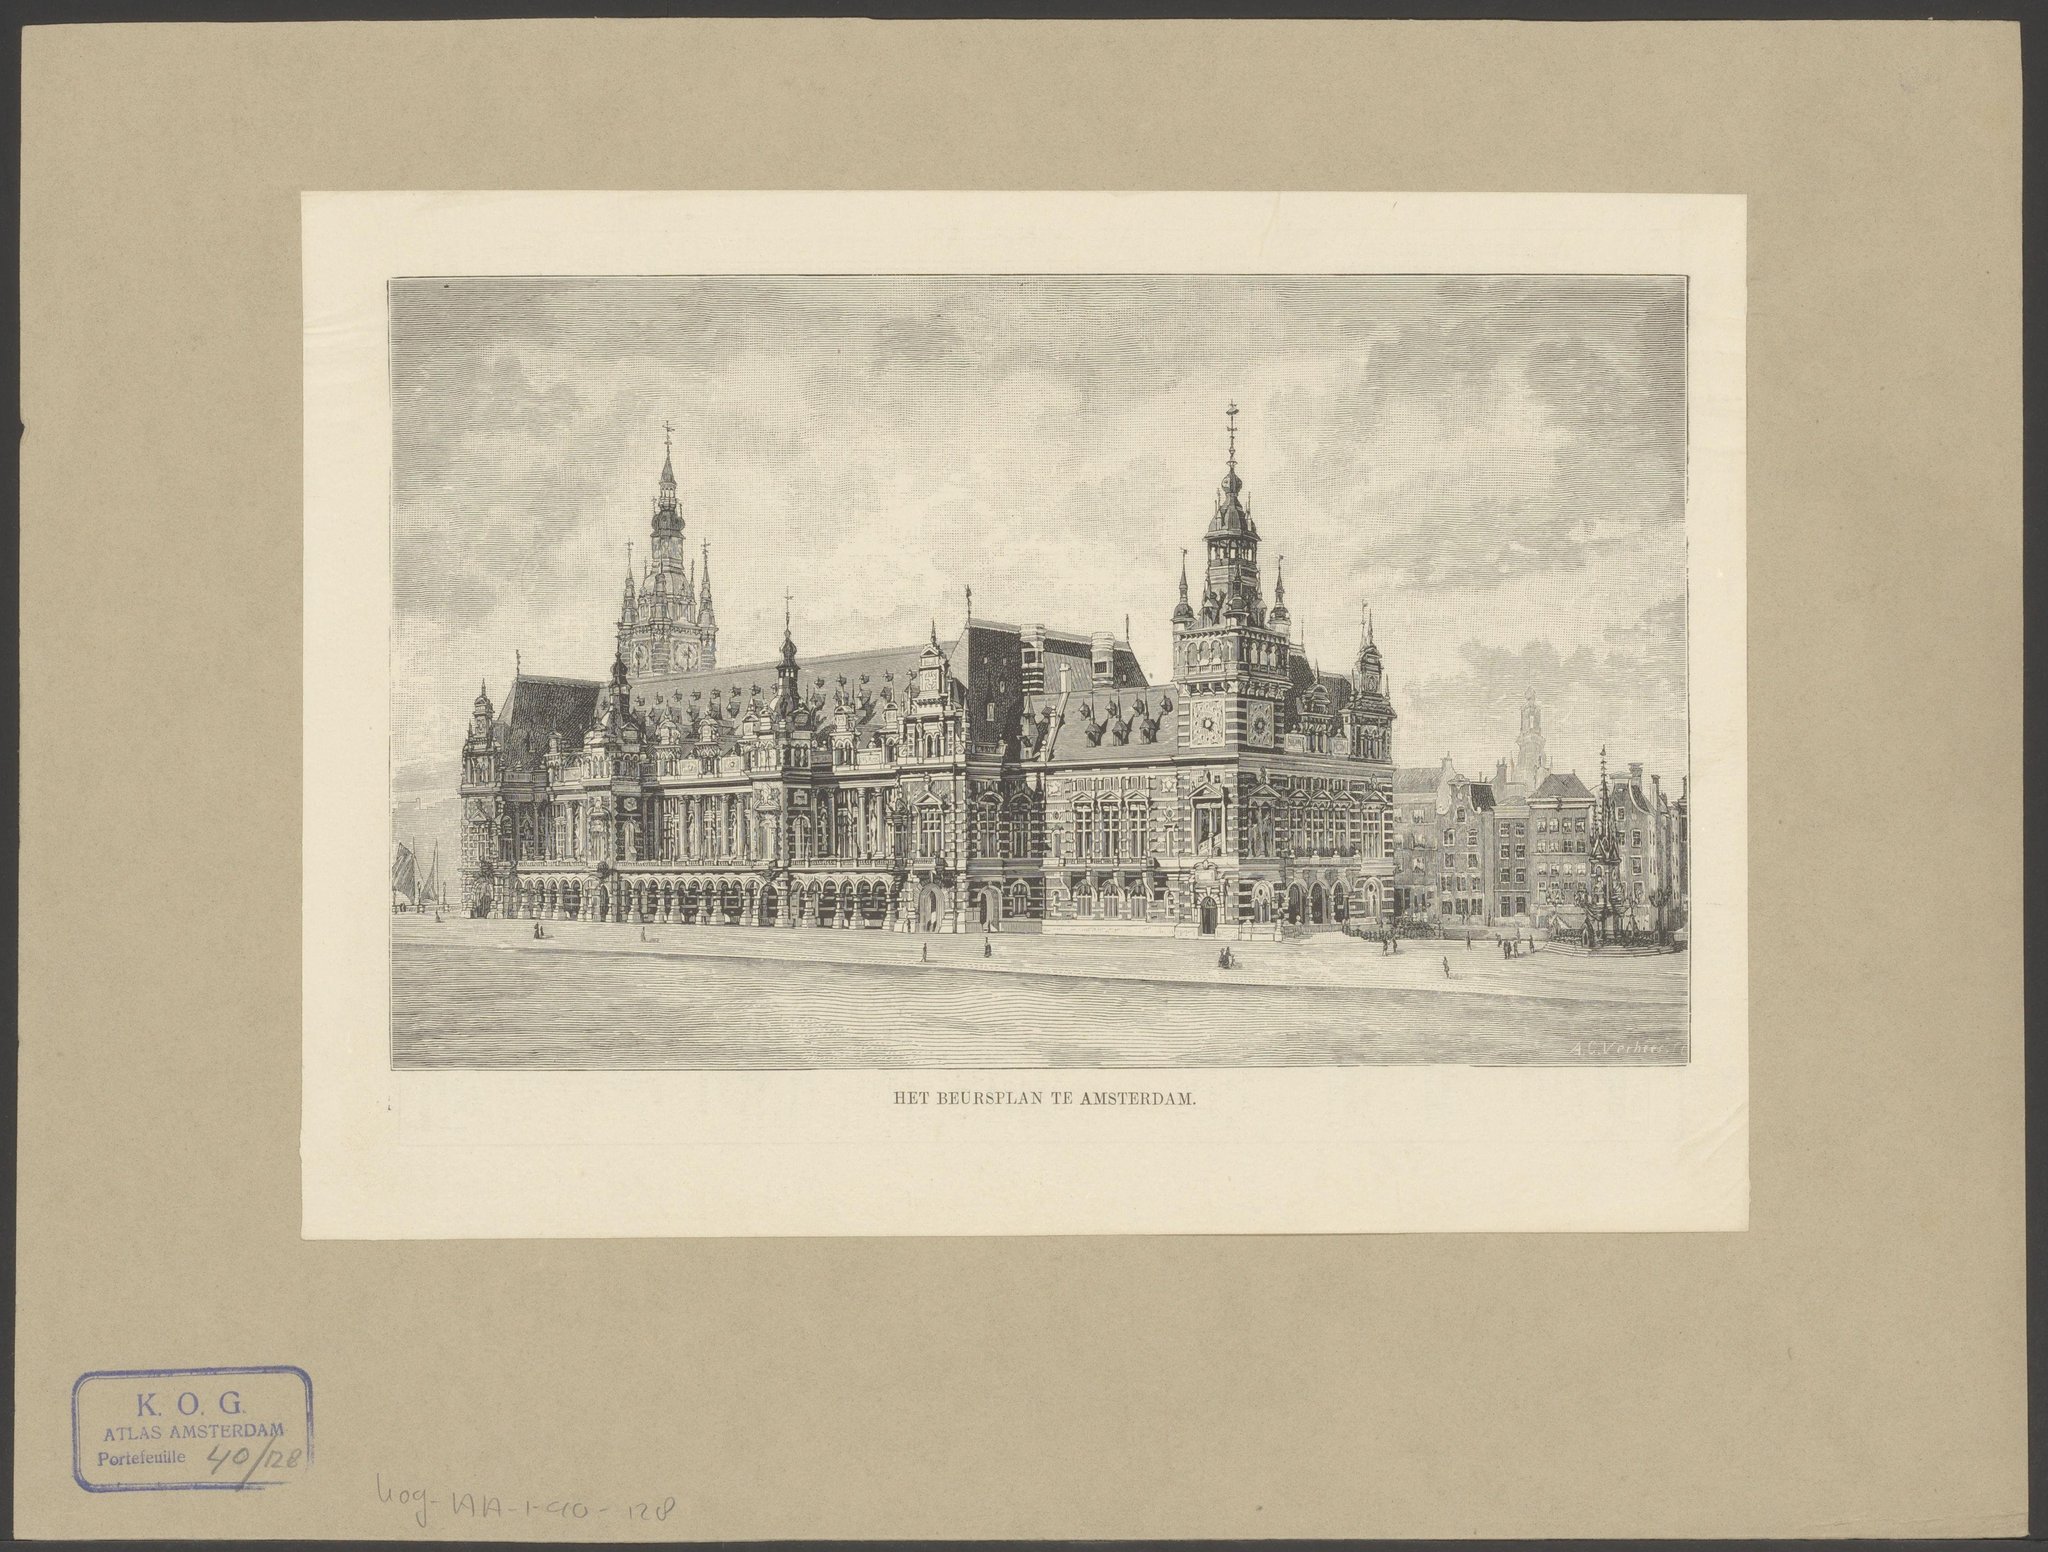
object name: print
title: Ontwerp voor een de Nieuwe Beurs in Amsterdam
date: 1886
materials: paper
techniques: letterpress printing, engraving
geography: haarlem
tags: stock exchange, stock-market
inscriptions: collector's mark: Lugt 1641b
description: Onderwerpsrubriek binnen de Atlas Amsterdam: Handel en Zeevaart, D. Beurs-Ontwerpen.